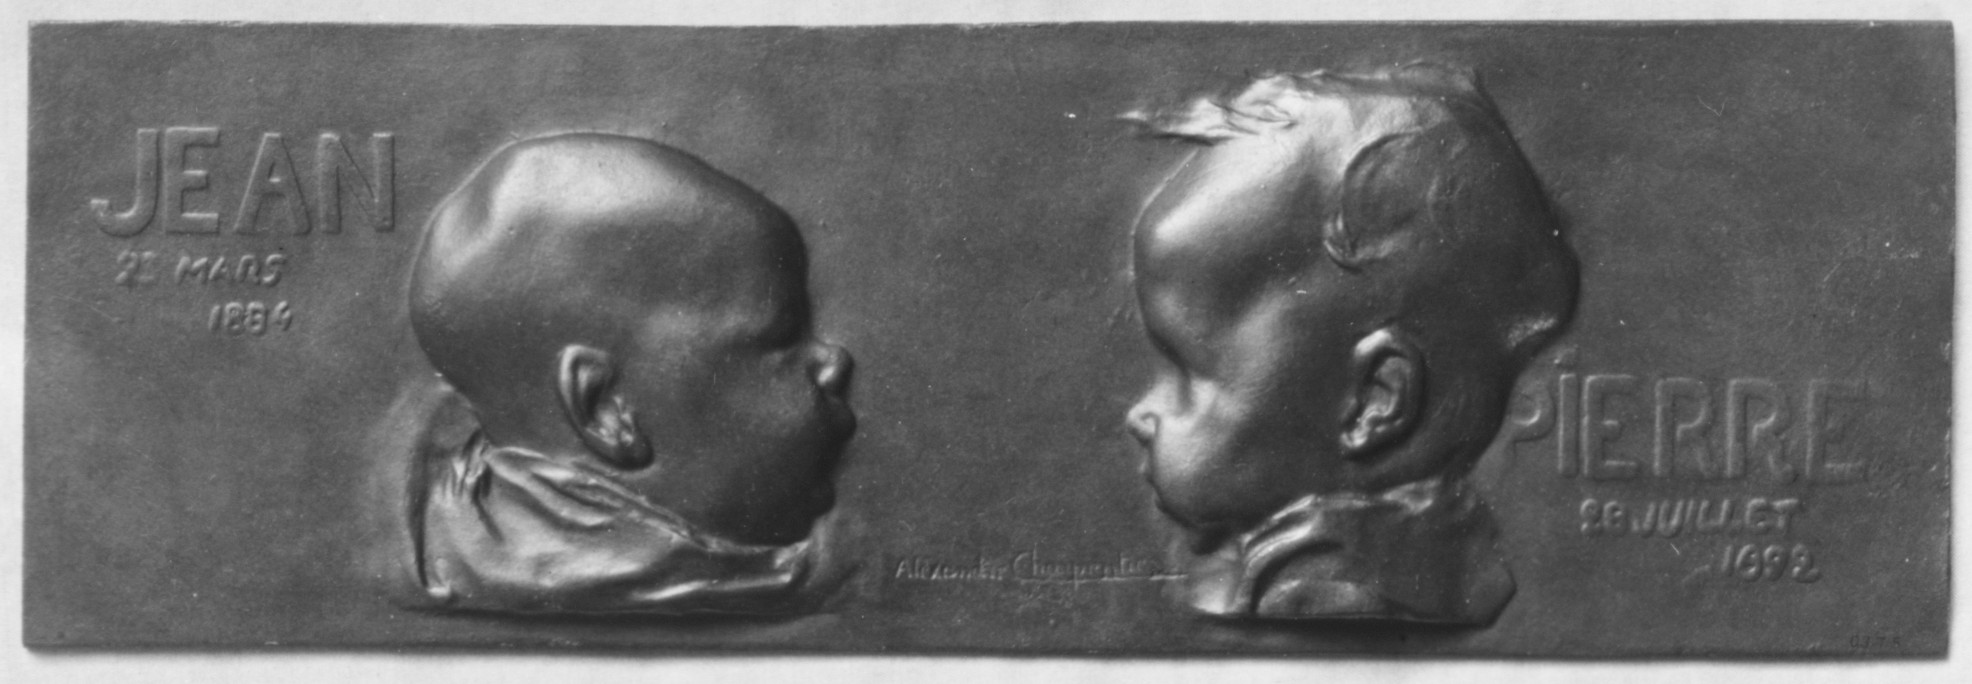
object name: plaque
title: Jean and Pierre Charpentier, the Artist's Sons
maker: alexandre-louis-marie charpentier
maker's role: artist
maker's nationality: french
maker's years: 1856-1909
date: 1899-1903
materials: bronze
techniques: casting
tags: infants,profiles